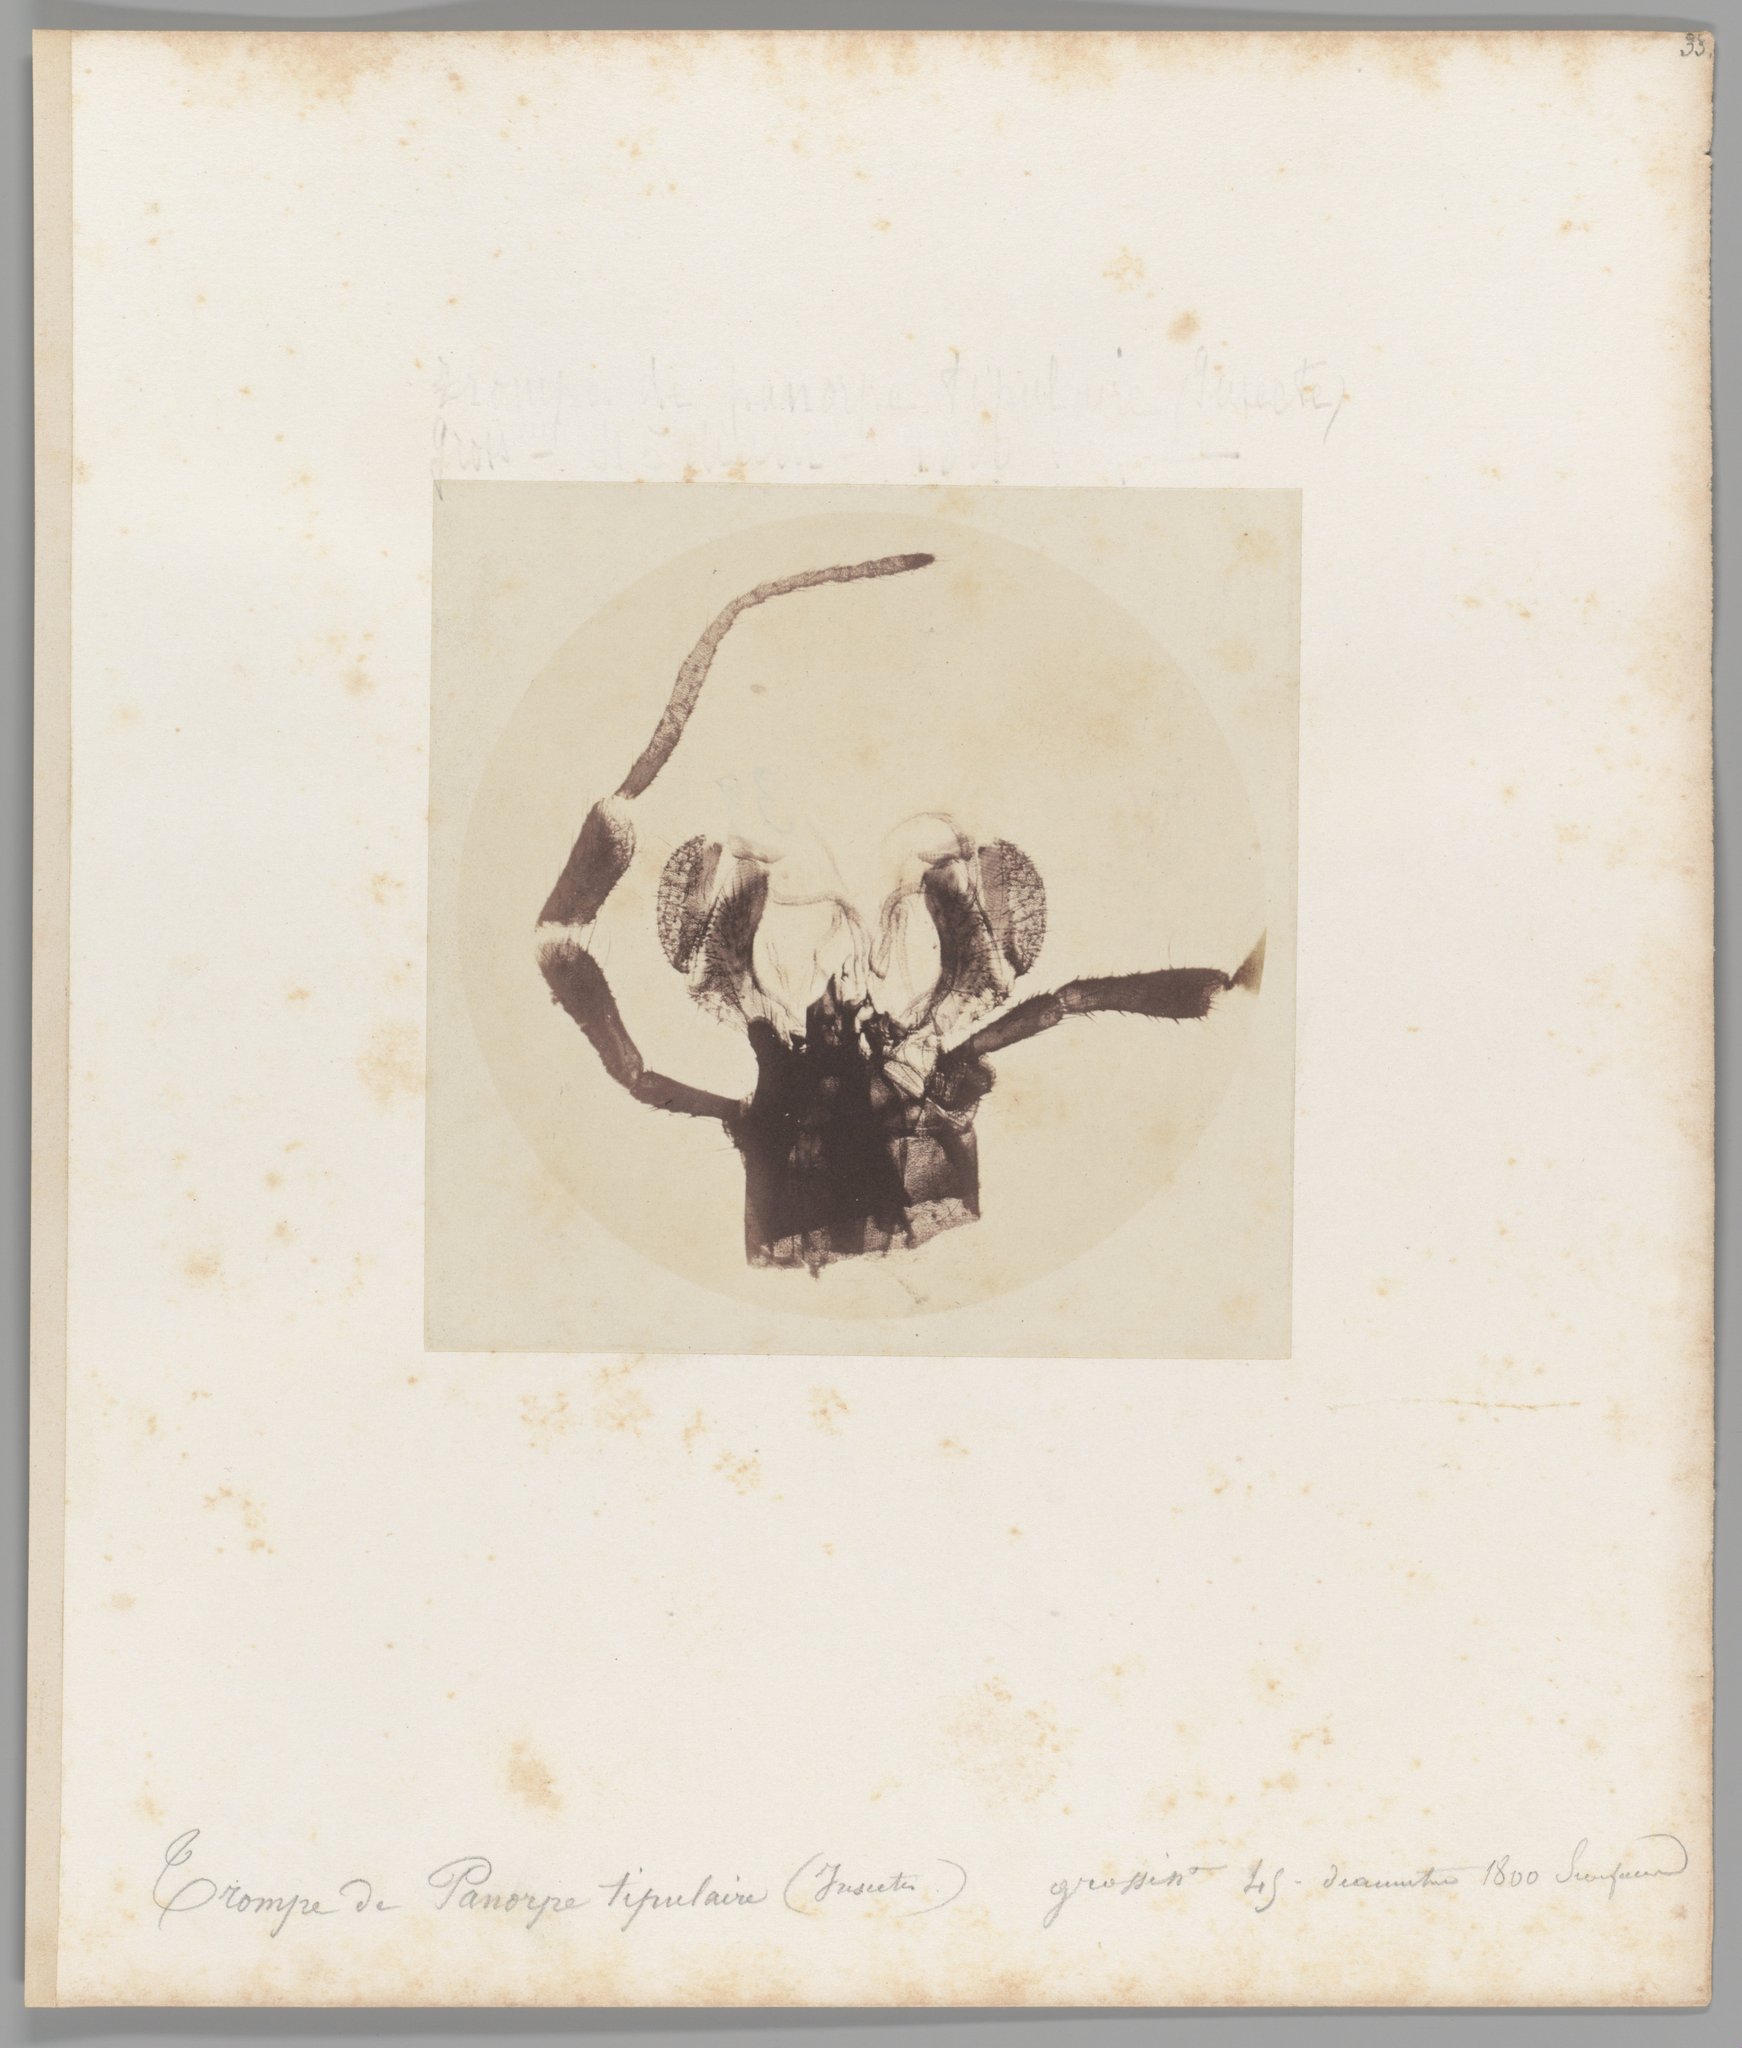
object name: photograph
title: [Untitled]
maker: auguste-adolphe bertsch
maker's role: artist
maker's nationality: french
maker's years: 1813-1871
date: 1853-1857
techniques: salted paper print